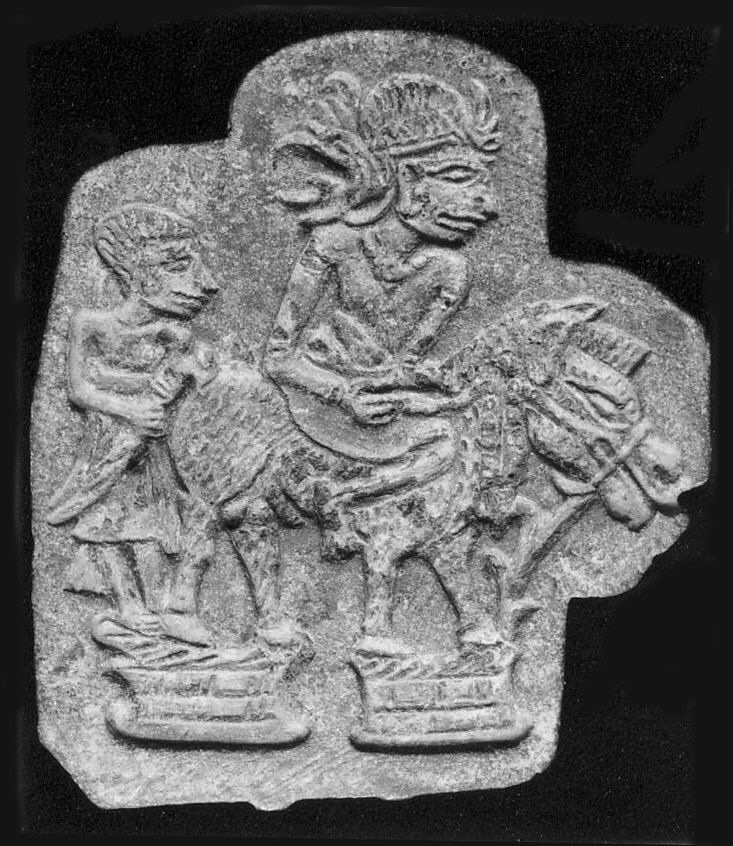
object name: mold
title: Mold of Figure on Horse with Attendant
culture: indonesian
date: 901-1100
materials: bronze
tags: horses